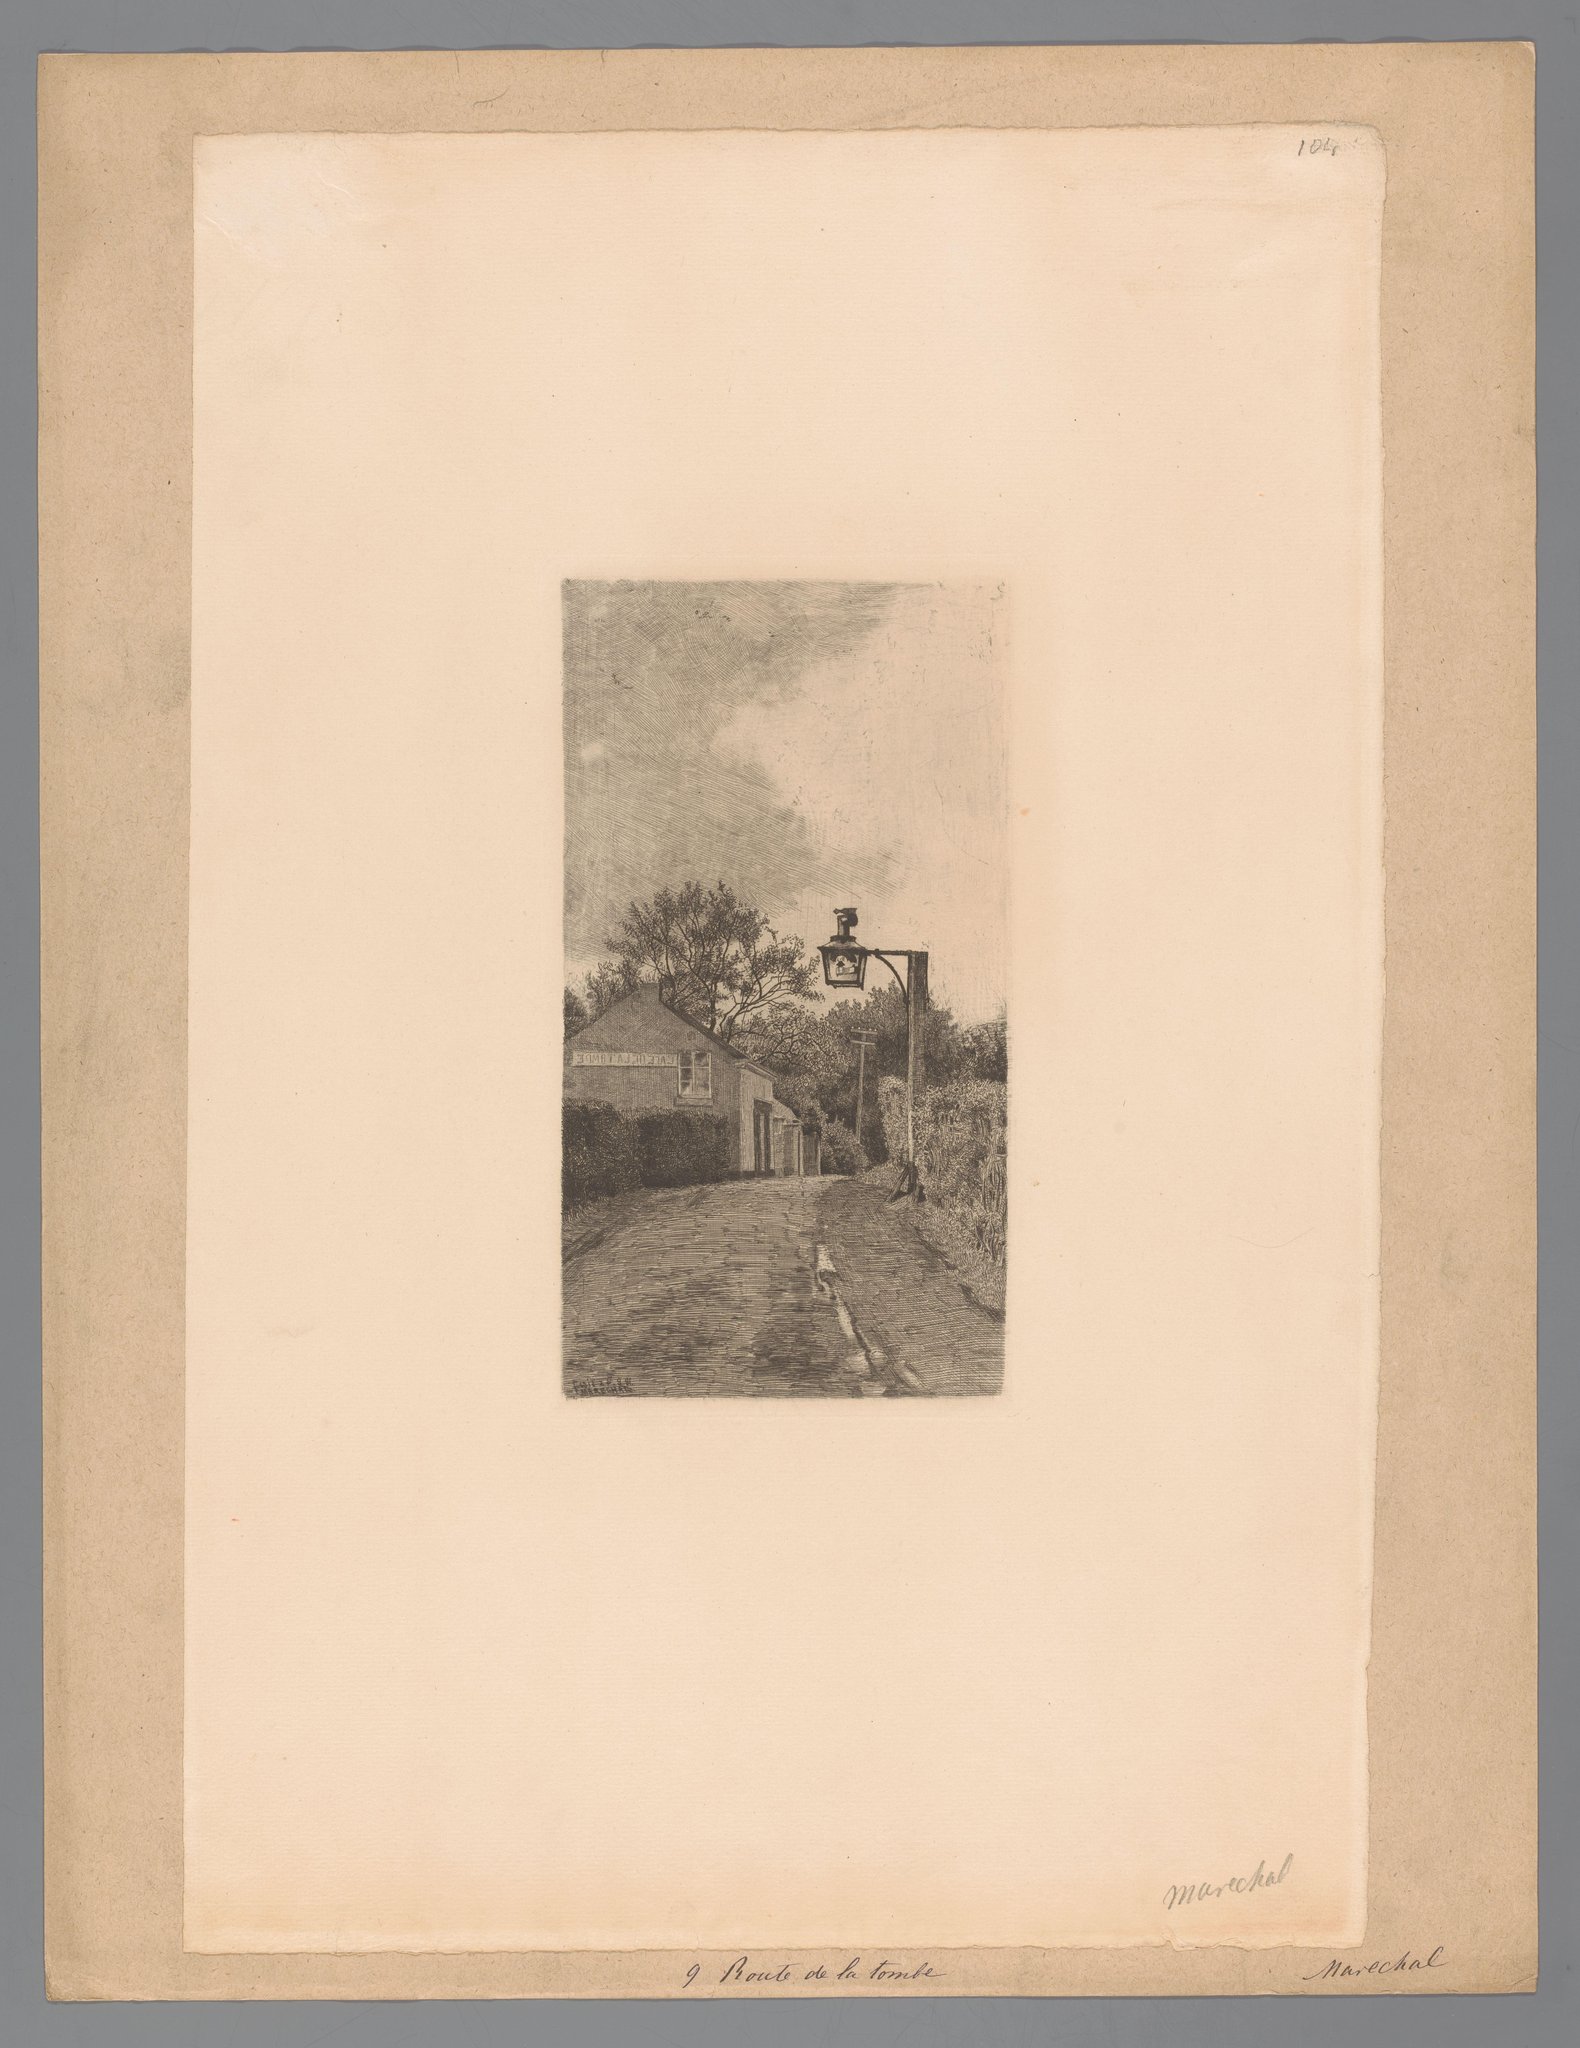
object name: print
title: Weg langs een lantaarn en bebouwing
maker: françois maréchal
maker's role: print maker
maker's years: 1861-1945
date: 1891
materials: paper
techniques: etching, intaglio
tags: street lighting, public road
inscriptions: collector's mark: Lugt 2228